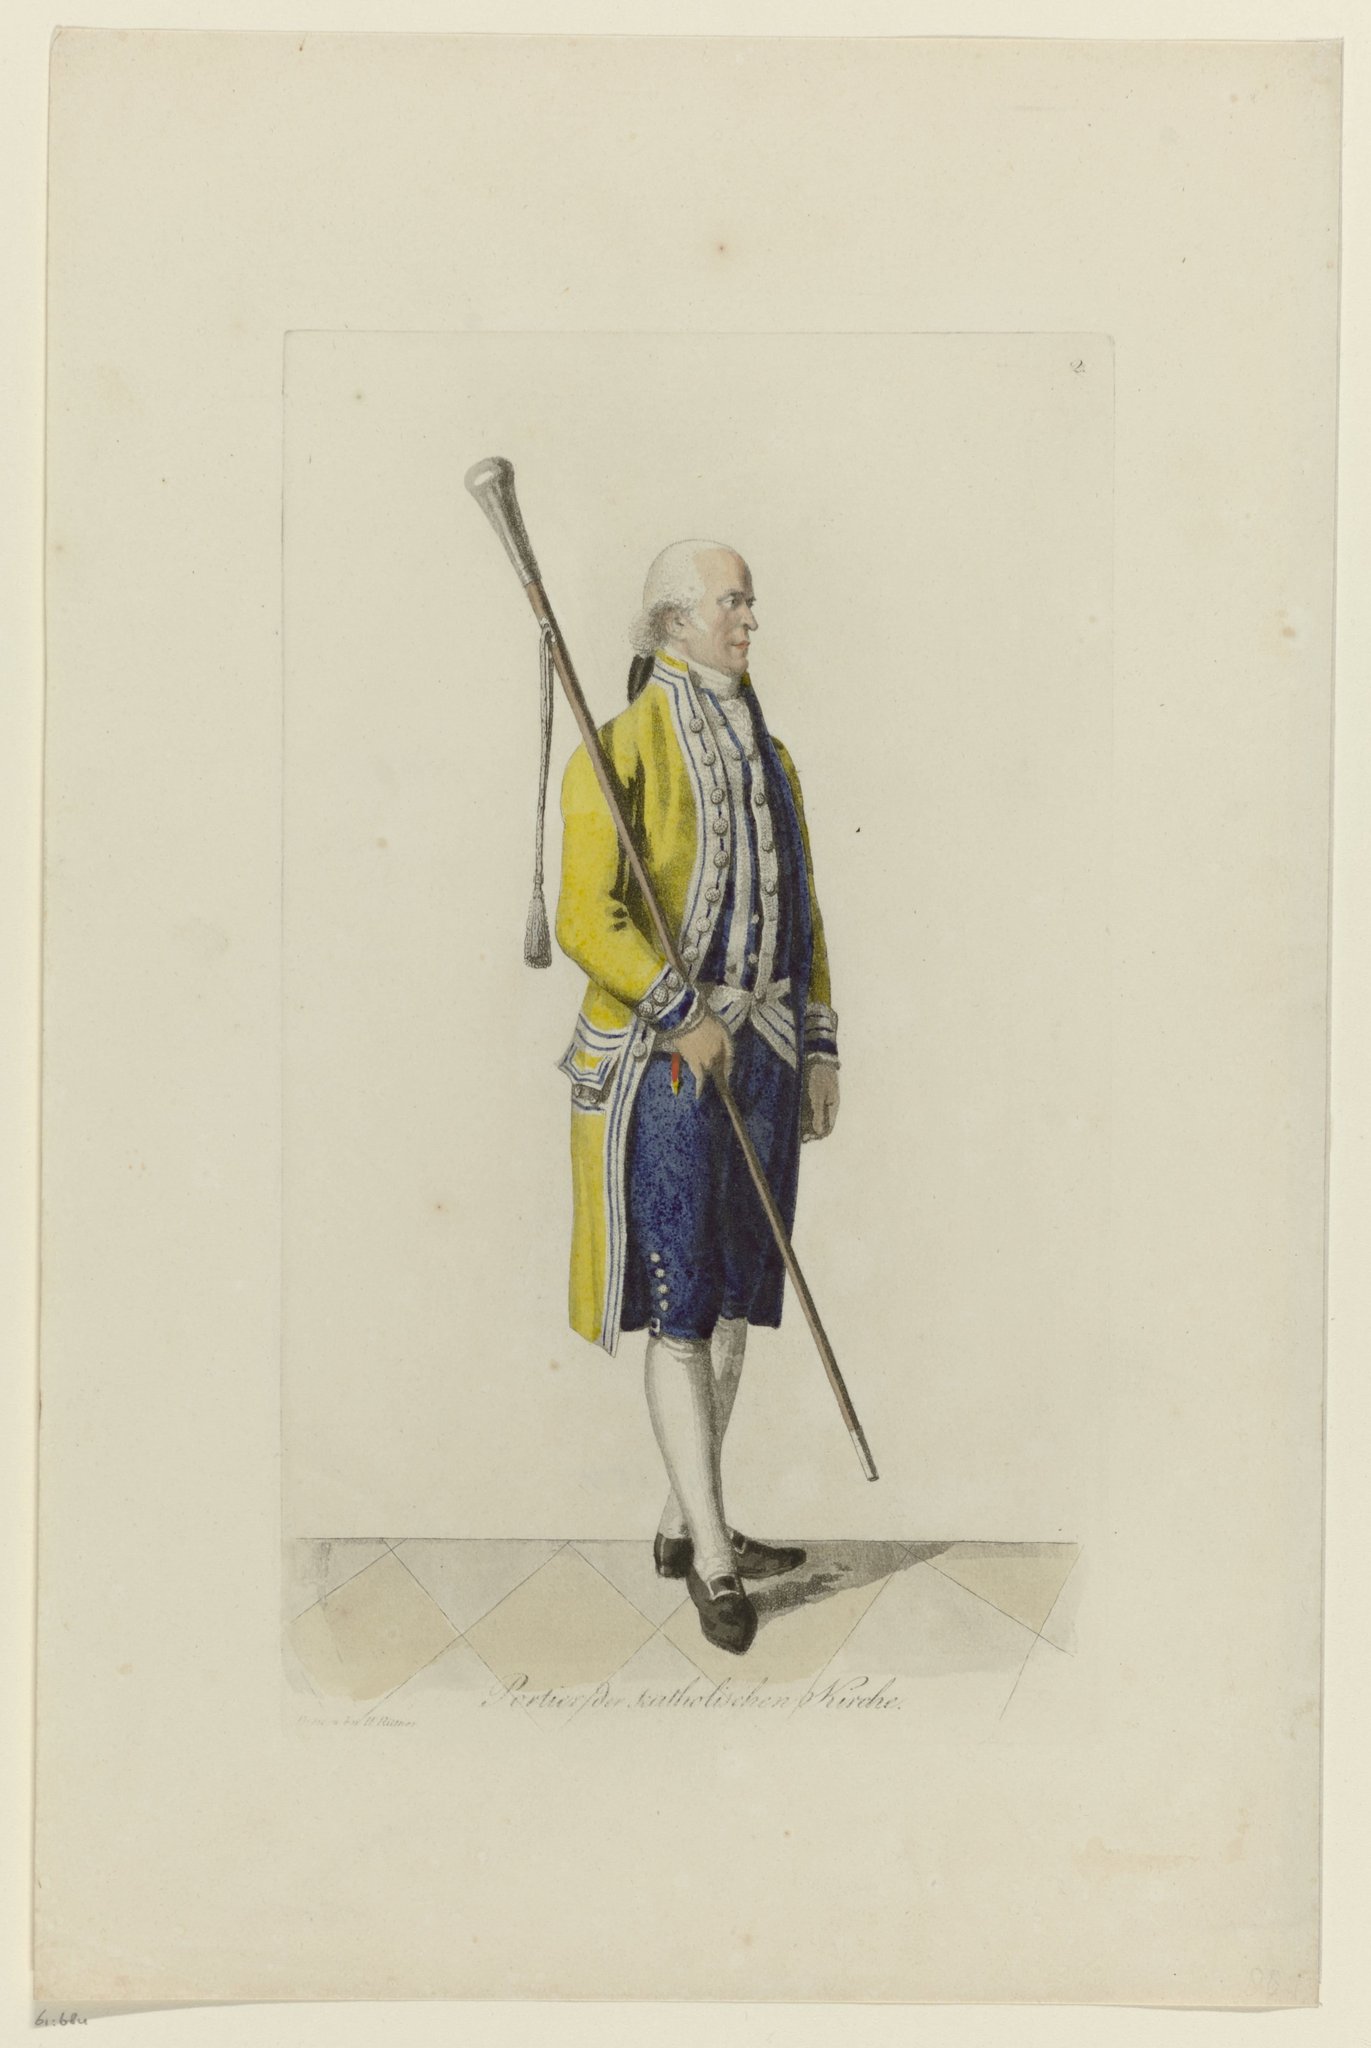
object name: costume print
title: Kostuum van een portier bij de Katholieke Kerk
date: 1803-1808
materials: paper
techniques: aquatint, etching, hand coloring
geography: dresden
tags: folk costume, regional costume, porter, bearer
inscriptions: collector's mark: Lugt 2228